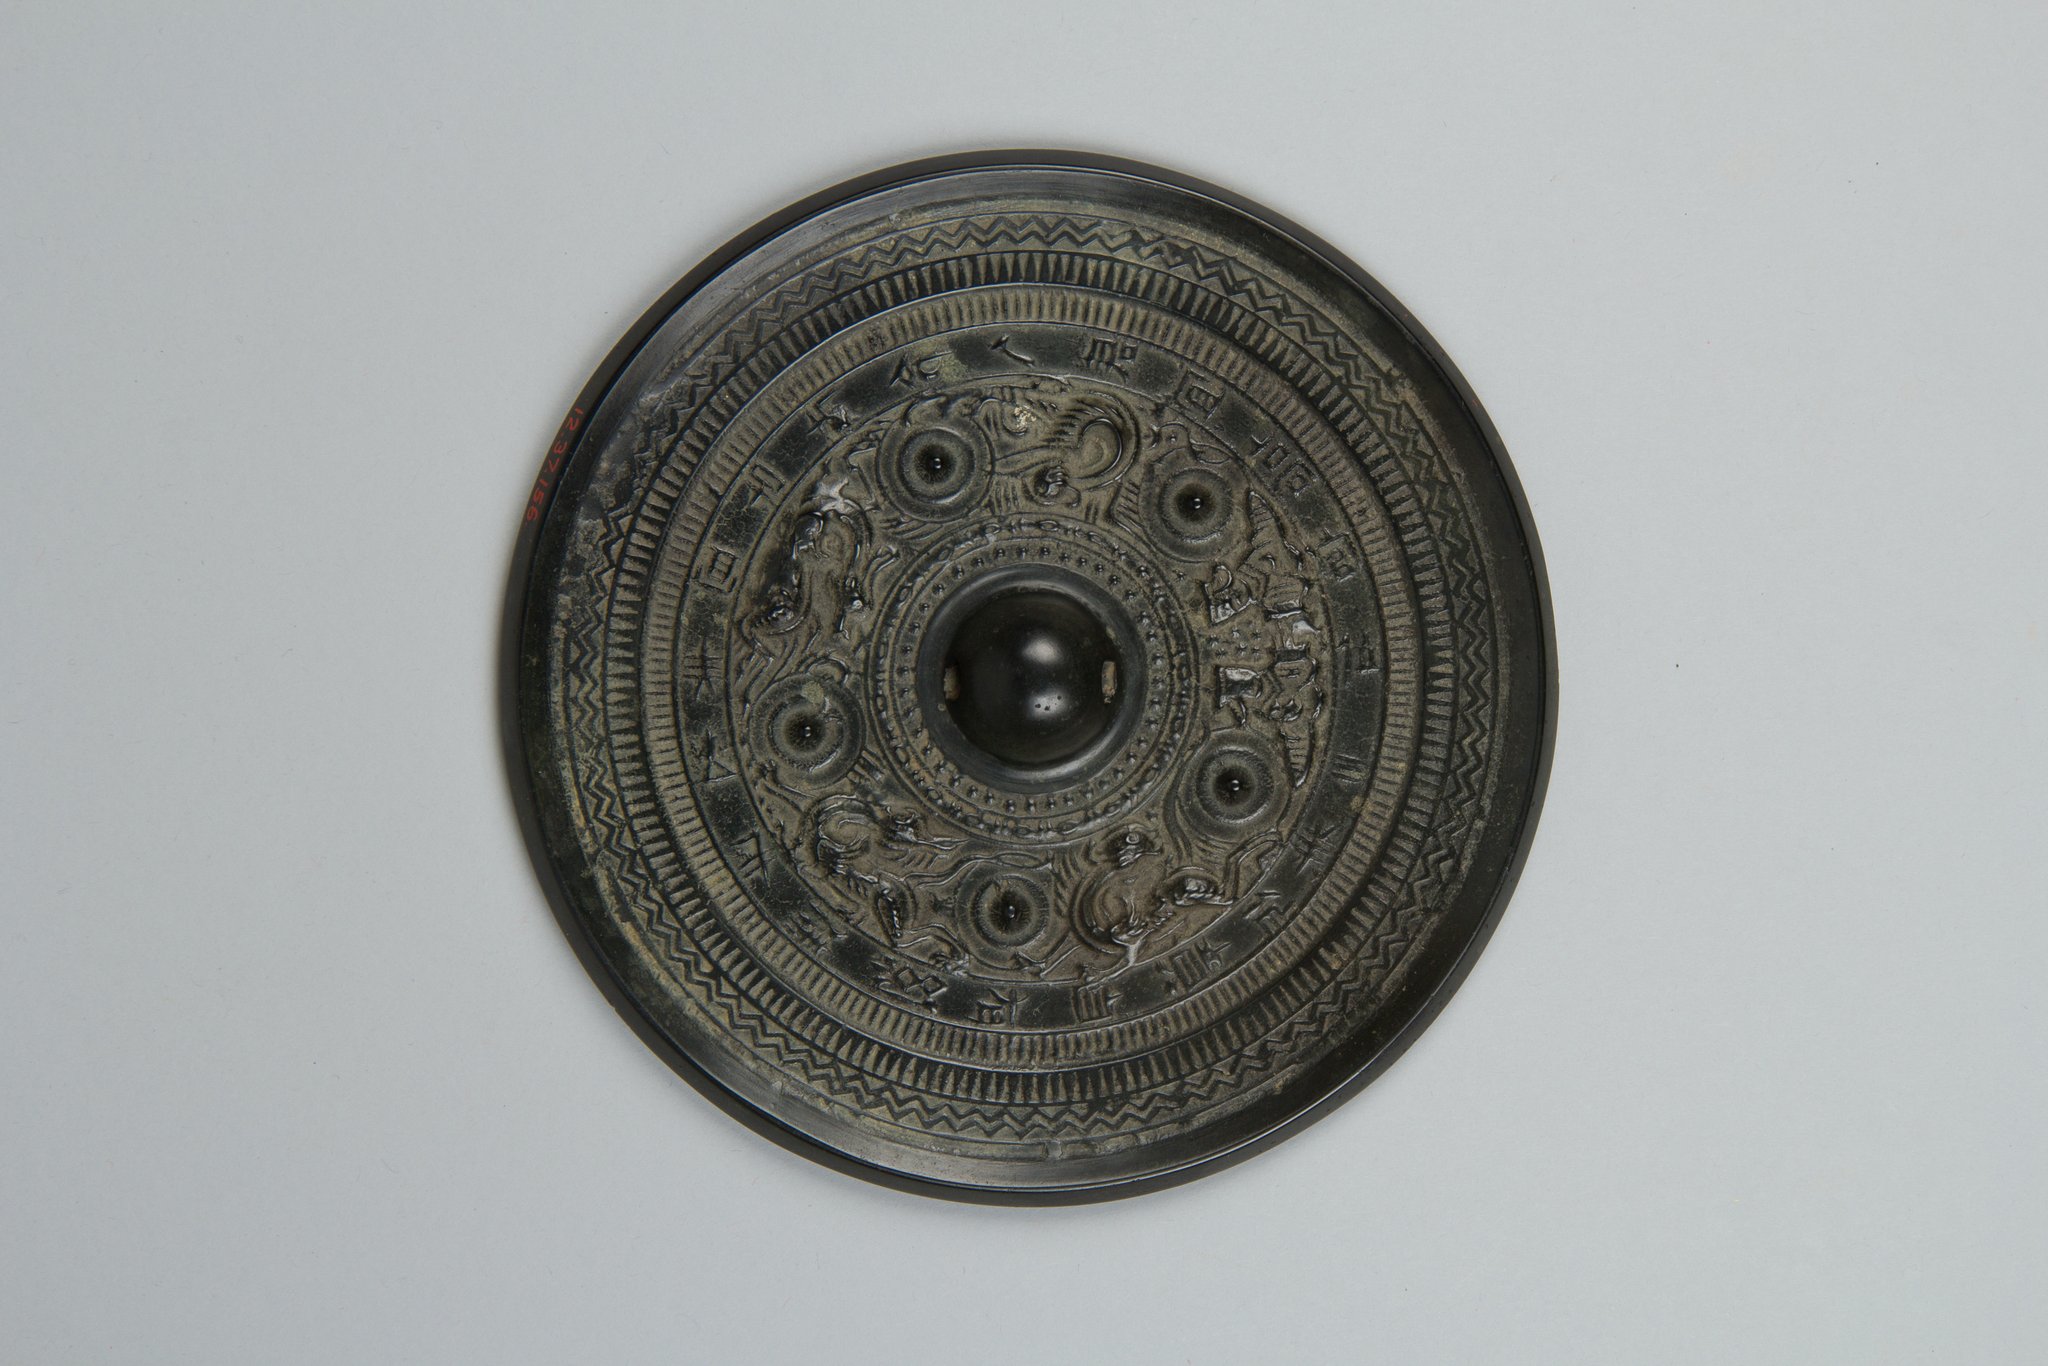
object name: mirror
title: Mirror with deities and mythical creatures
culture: chinese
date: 167-200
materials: bronze, patina